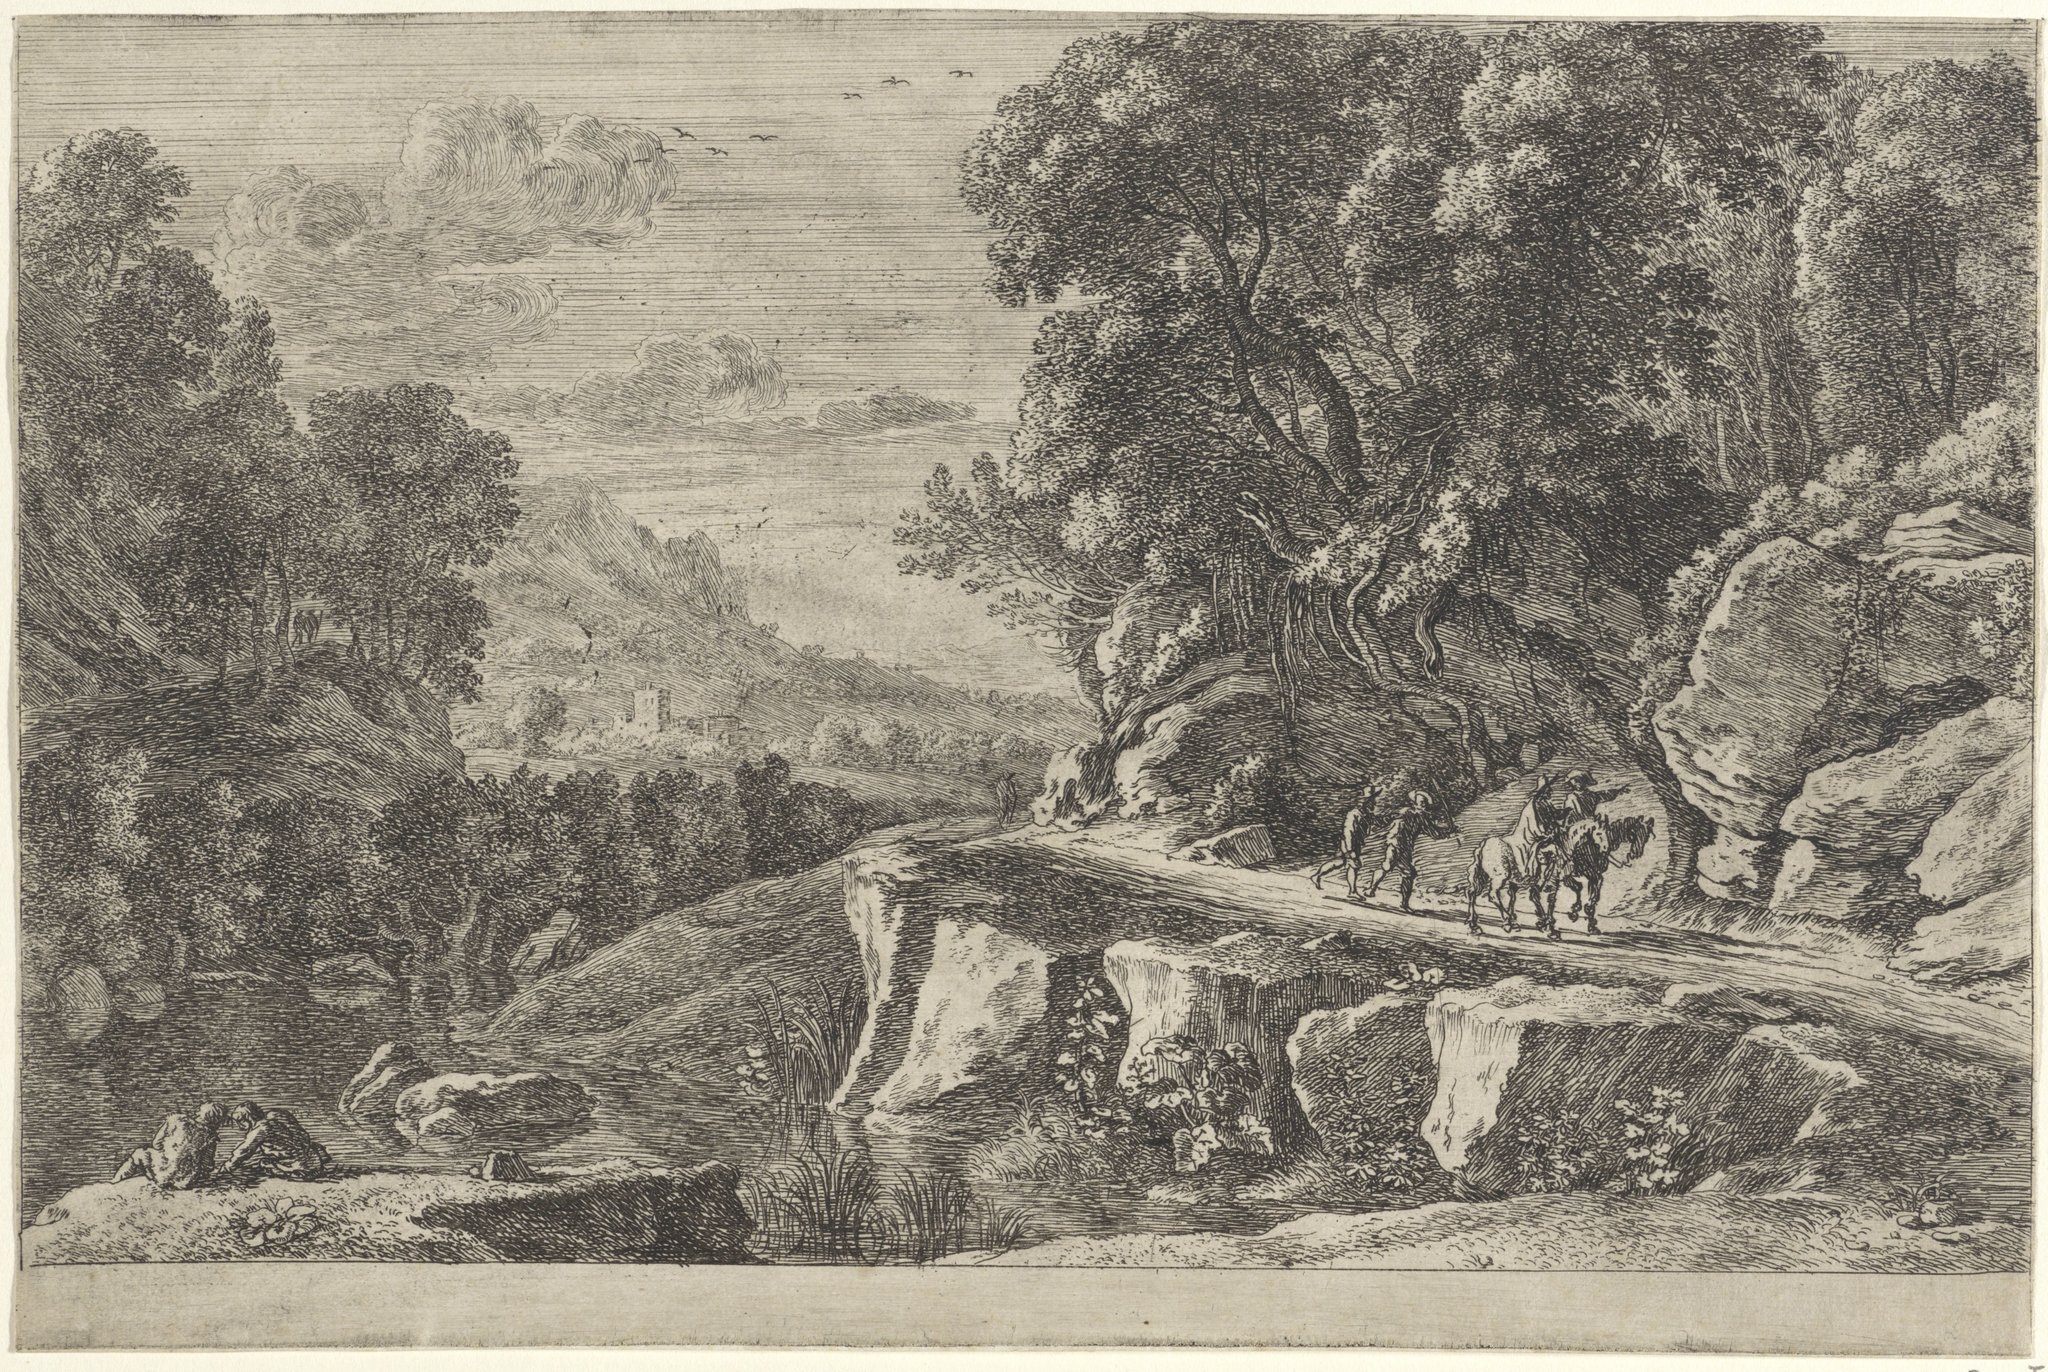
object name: print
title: Landschap met twee ruiters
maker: herman van swanevelt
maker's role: draughtsman, painter, print maker, publisher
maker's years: 1603-1655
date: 1643-1655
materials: paper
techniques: etching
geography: paris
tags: riding a horse, ass, or mule; rider, horseman, river, rural housing, e.g. country-house, villa, cottage, 'en route', traveller under way, mountains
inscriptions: collector's mark: Lugt 2228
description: Op een pad in een bergachtig landschap rijden twee ruiters. Achter hen lopen enkele figuren. Vooraan links zitten twee figuren bij een rivier.